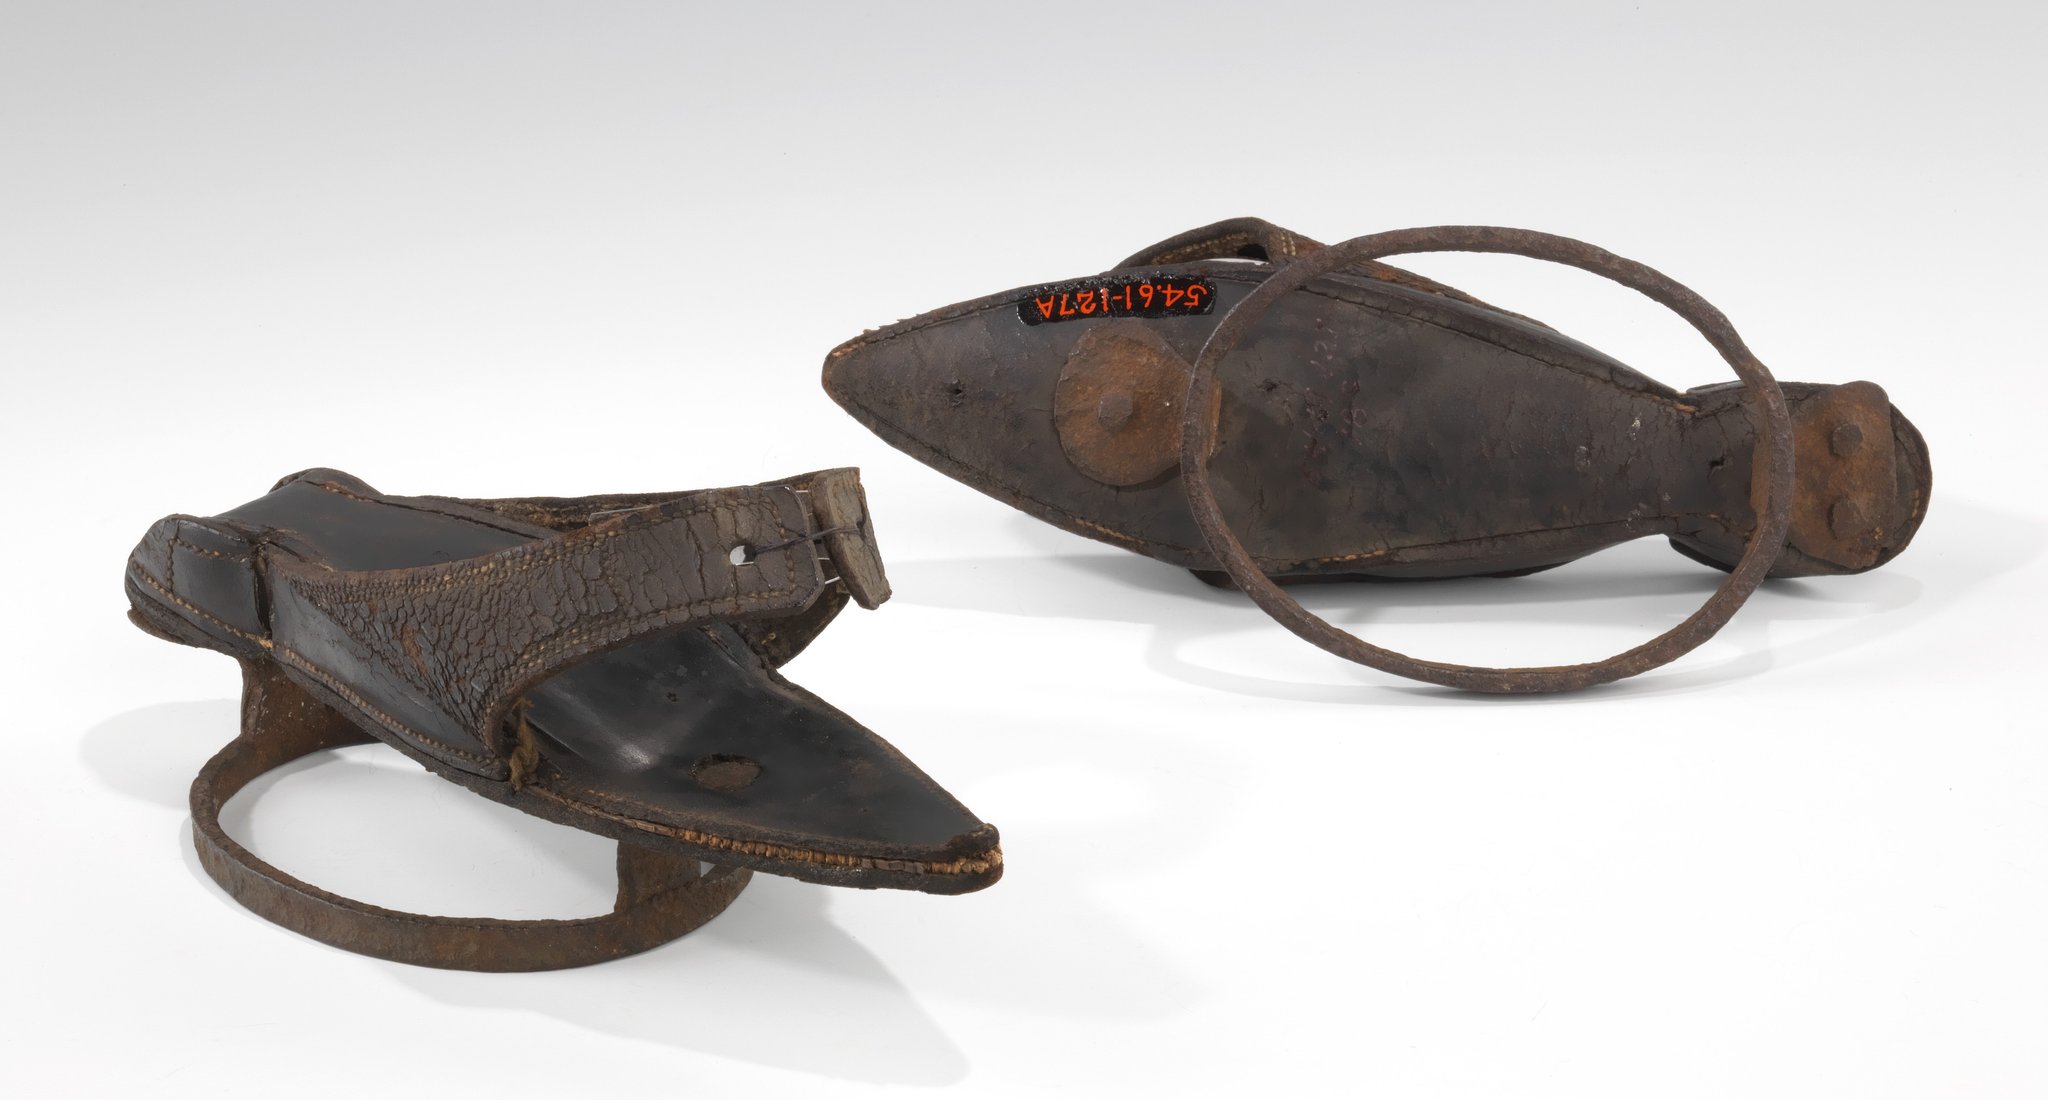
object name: patten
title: Pattens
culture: european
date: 1701-1800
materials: leather, metal